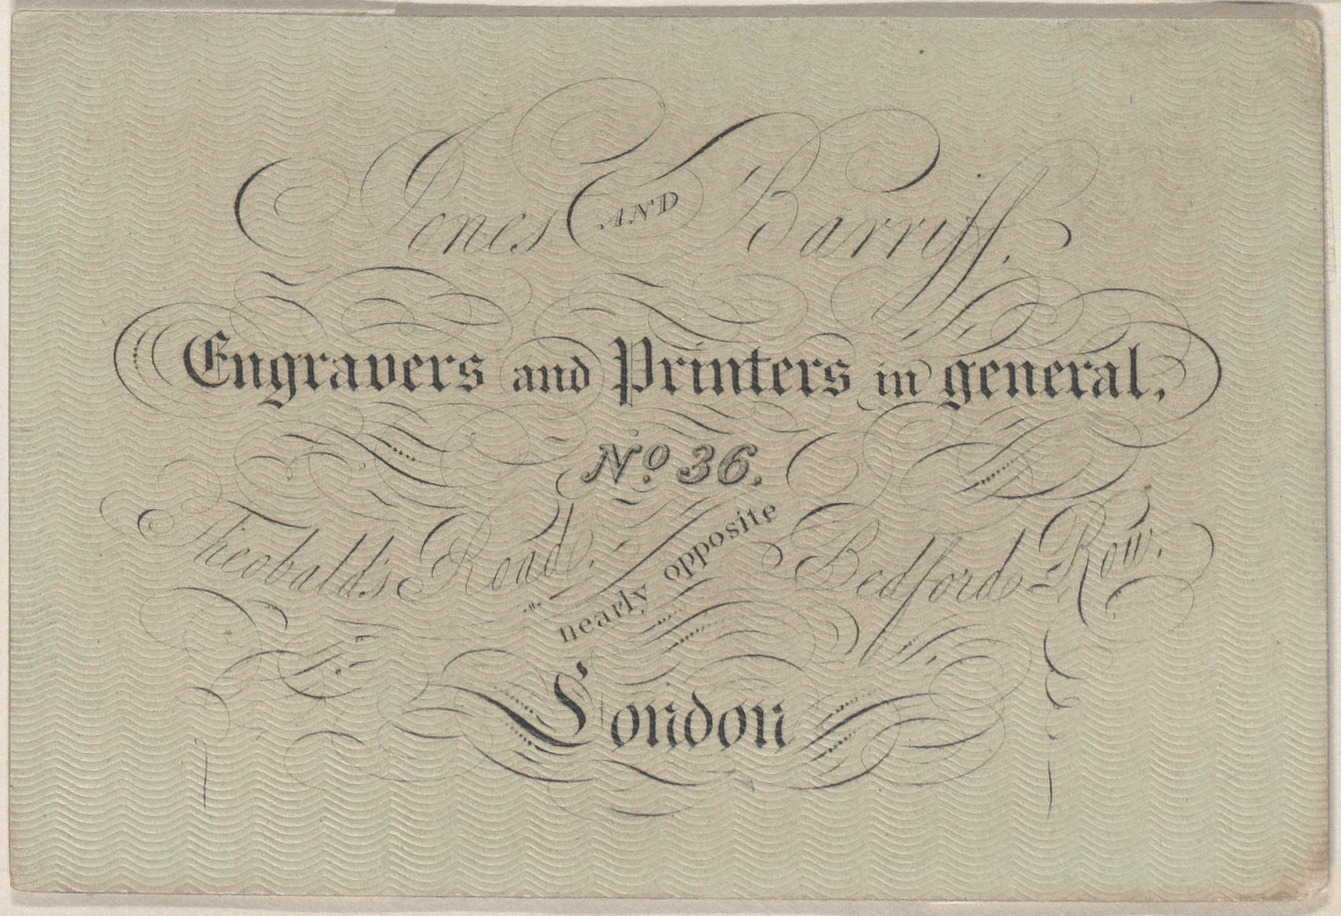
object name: print, trade card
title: Trade Card for Jones and Barriff, Engravers and Printers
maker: anonymous, british, 19th century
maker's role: artist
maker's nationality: british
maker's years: 1800-1900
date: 1801-1900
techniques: engraving